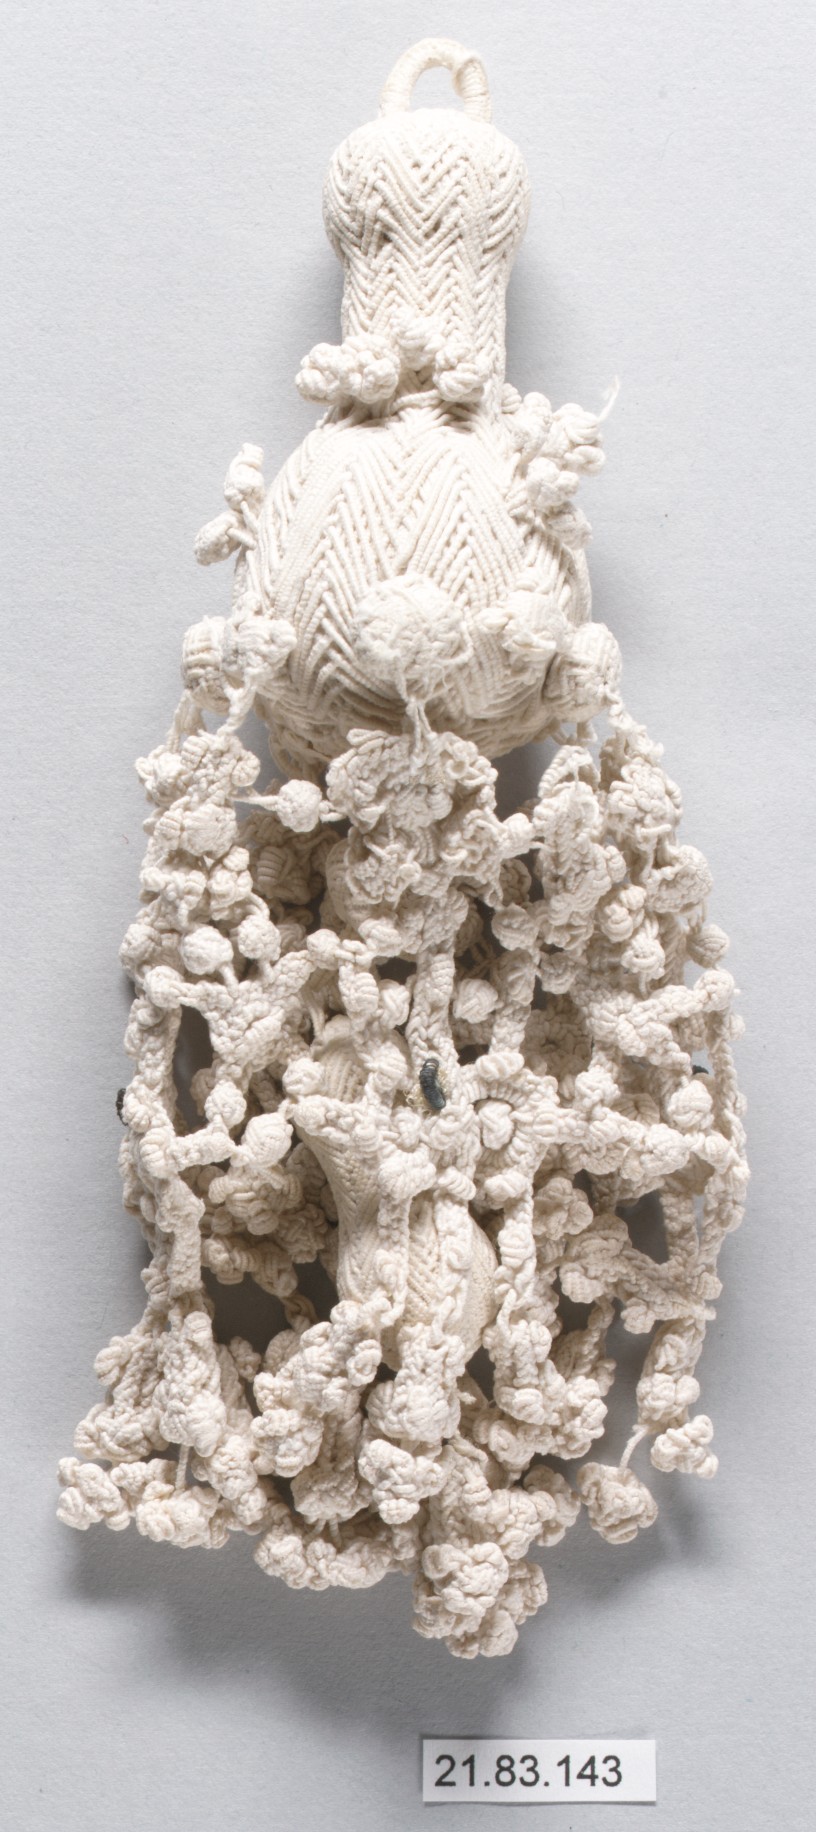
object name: tassel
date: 1601-1700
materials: linen